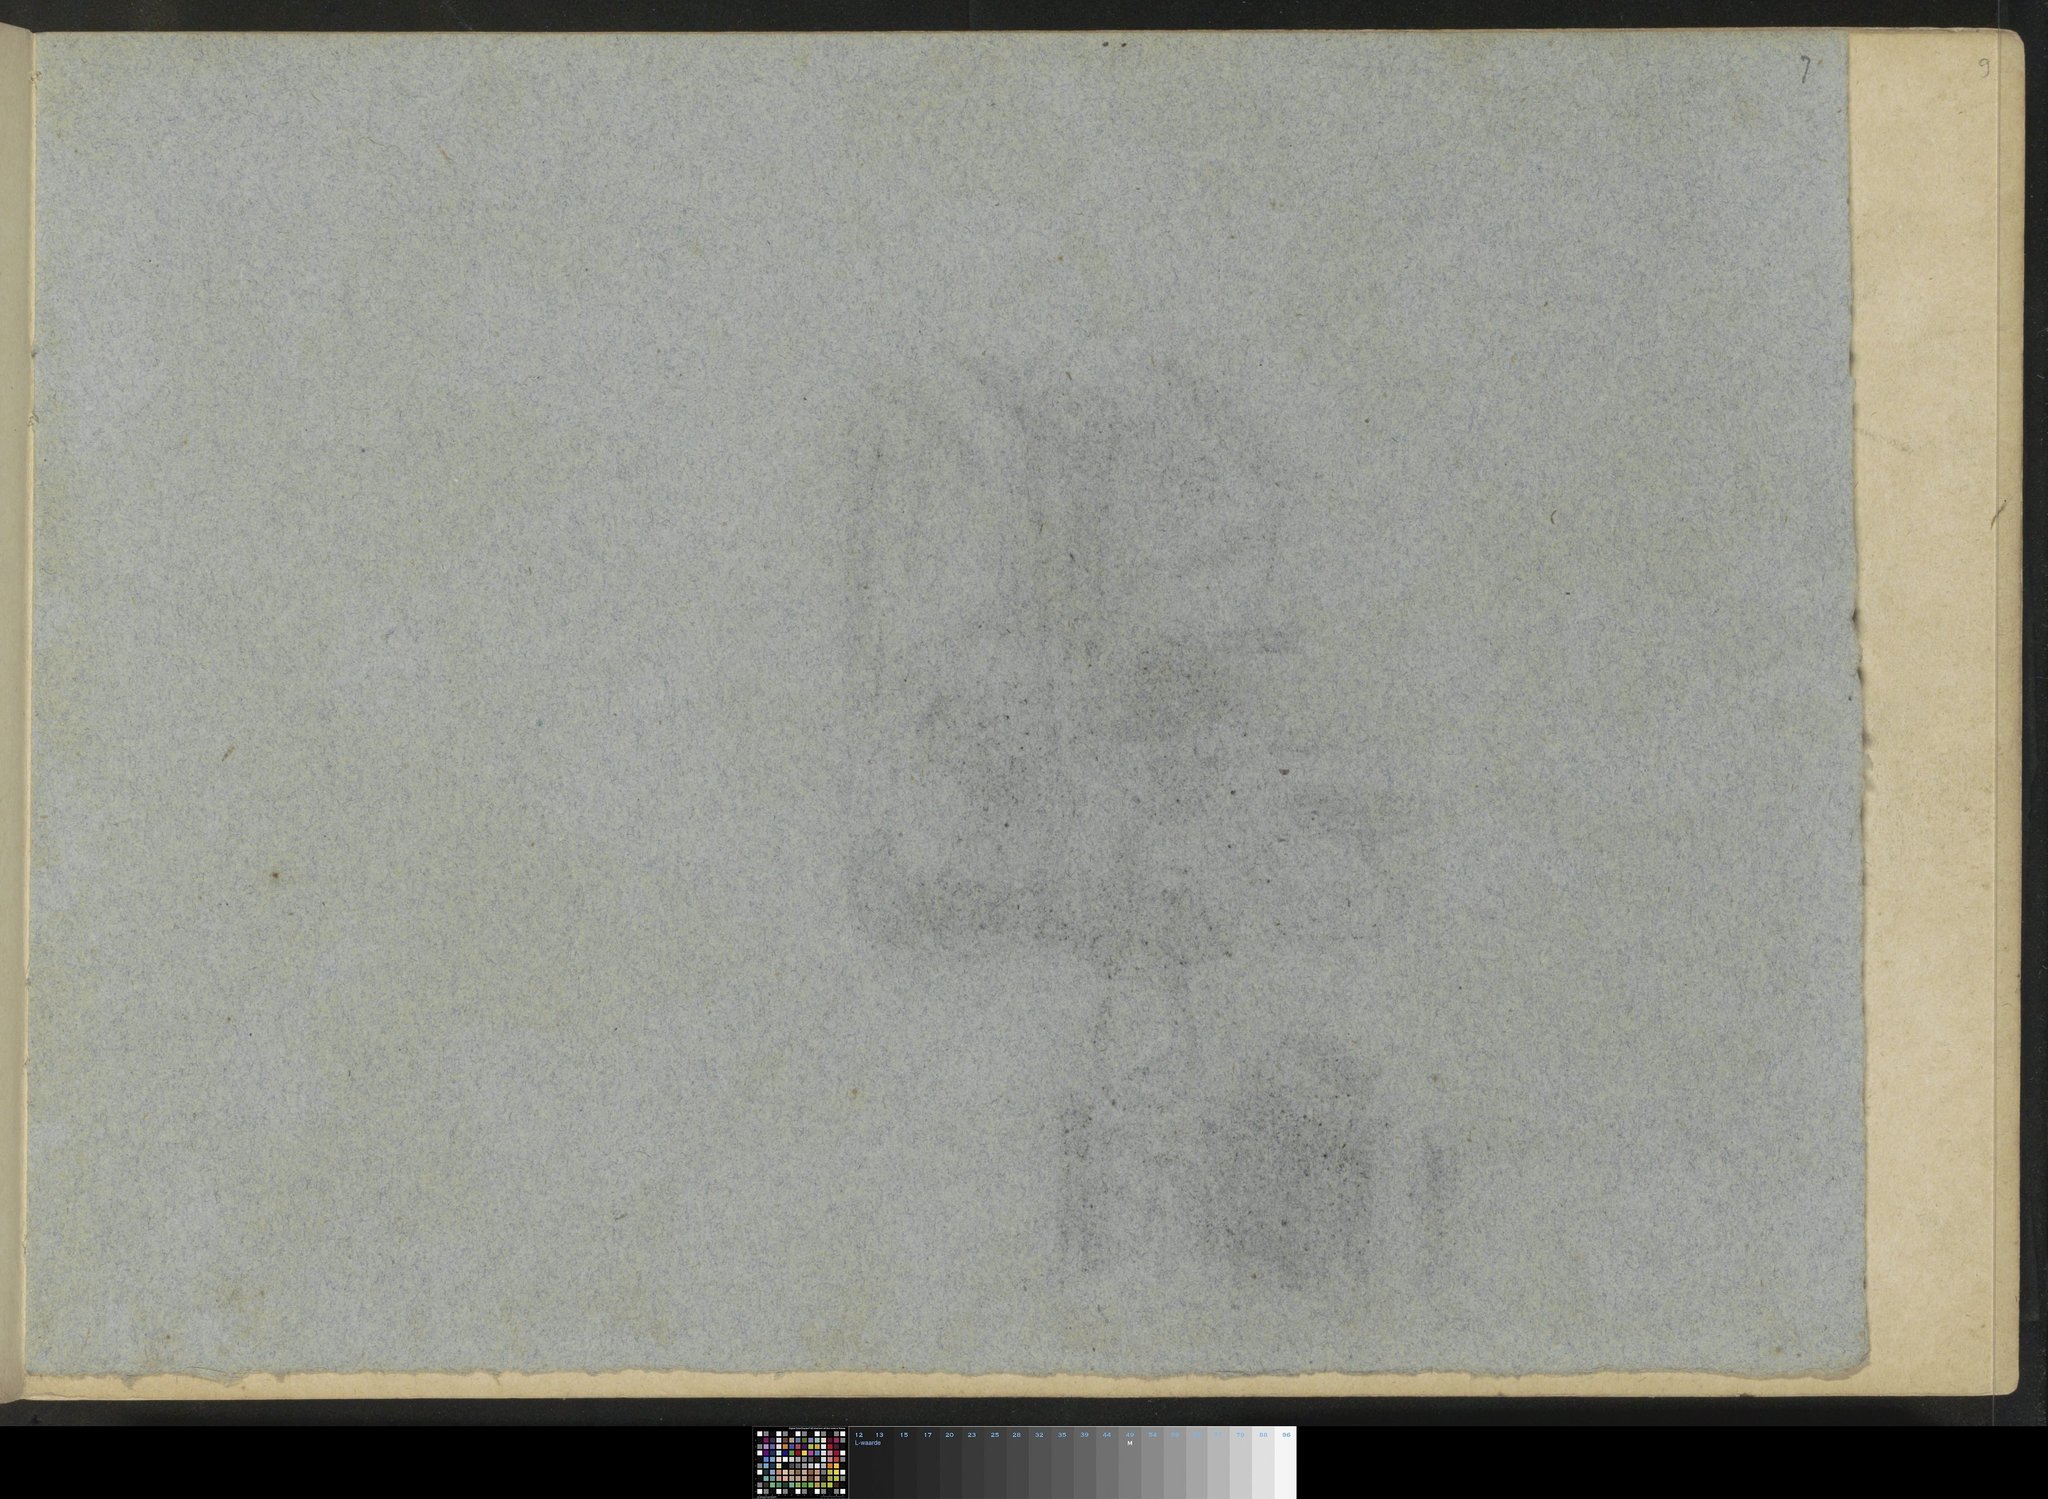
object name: sketchbook leaf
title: Abklatsch van de krijttekening op pagina 6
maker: willem witsen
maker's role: draughtsman, painter, print maker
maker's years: 1860-1923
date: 1884-1887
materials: paper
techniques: printmaking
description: Pagina 7 uit een schetsboek met 29 bladen.